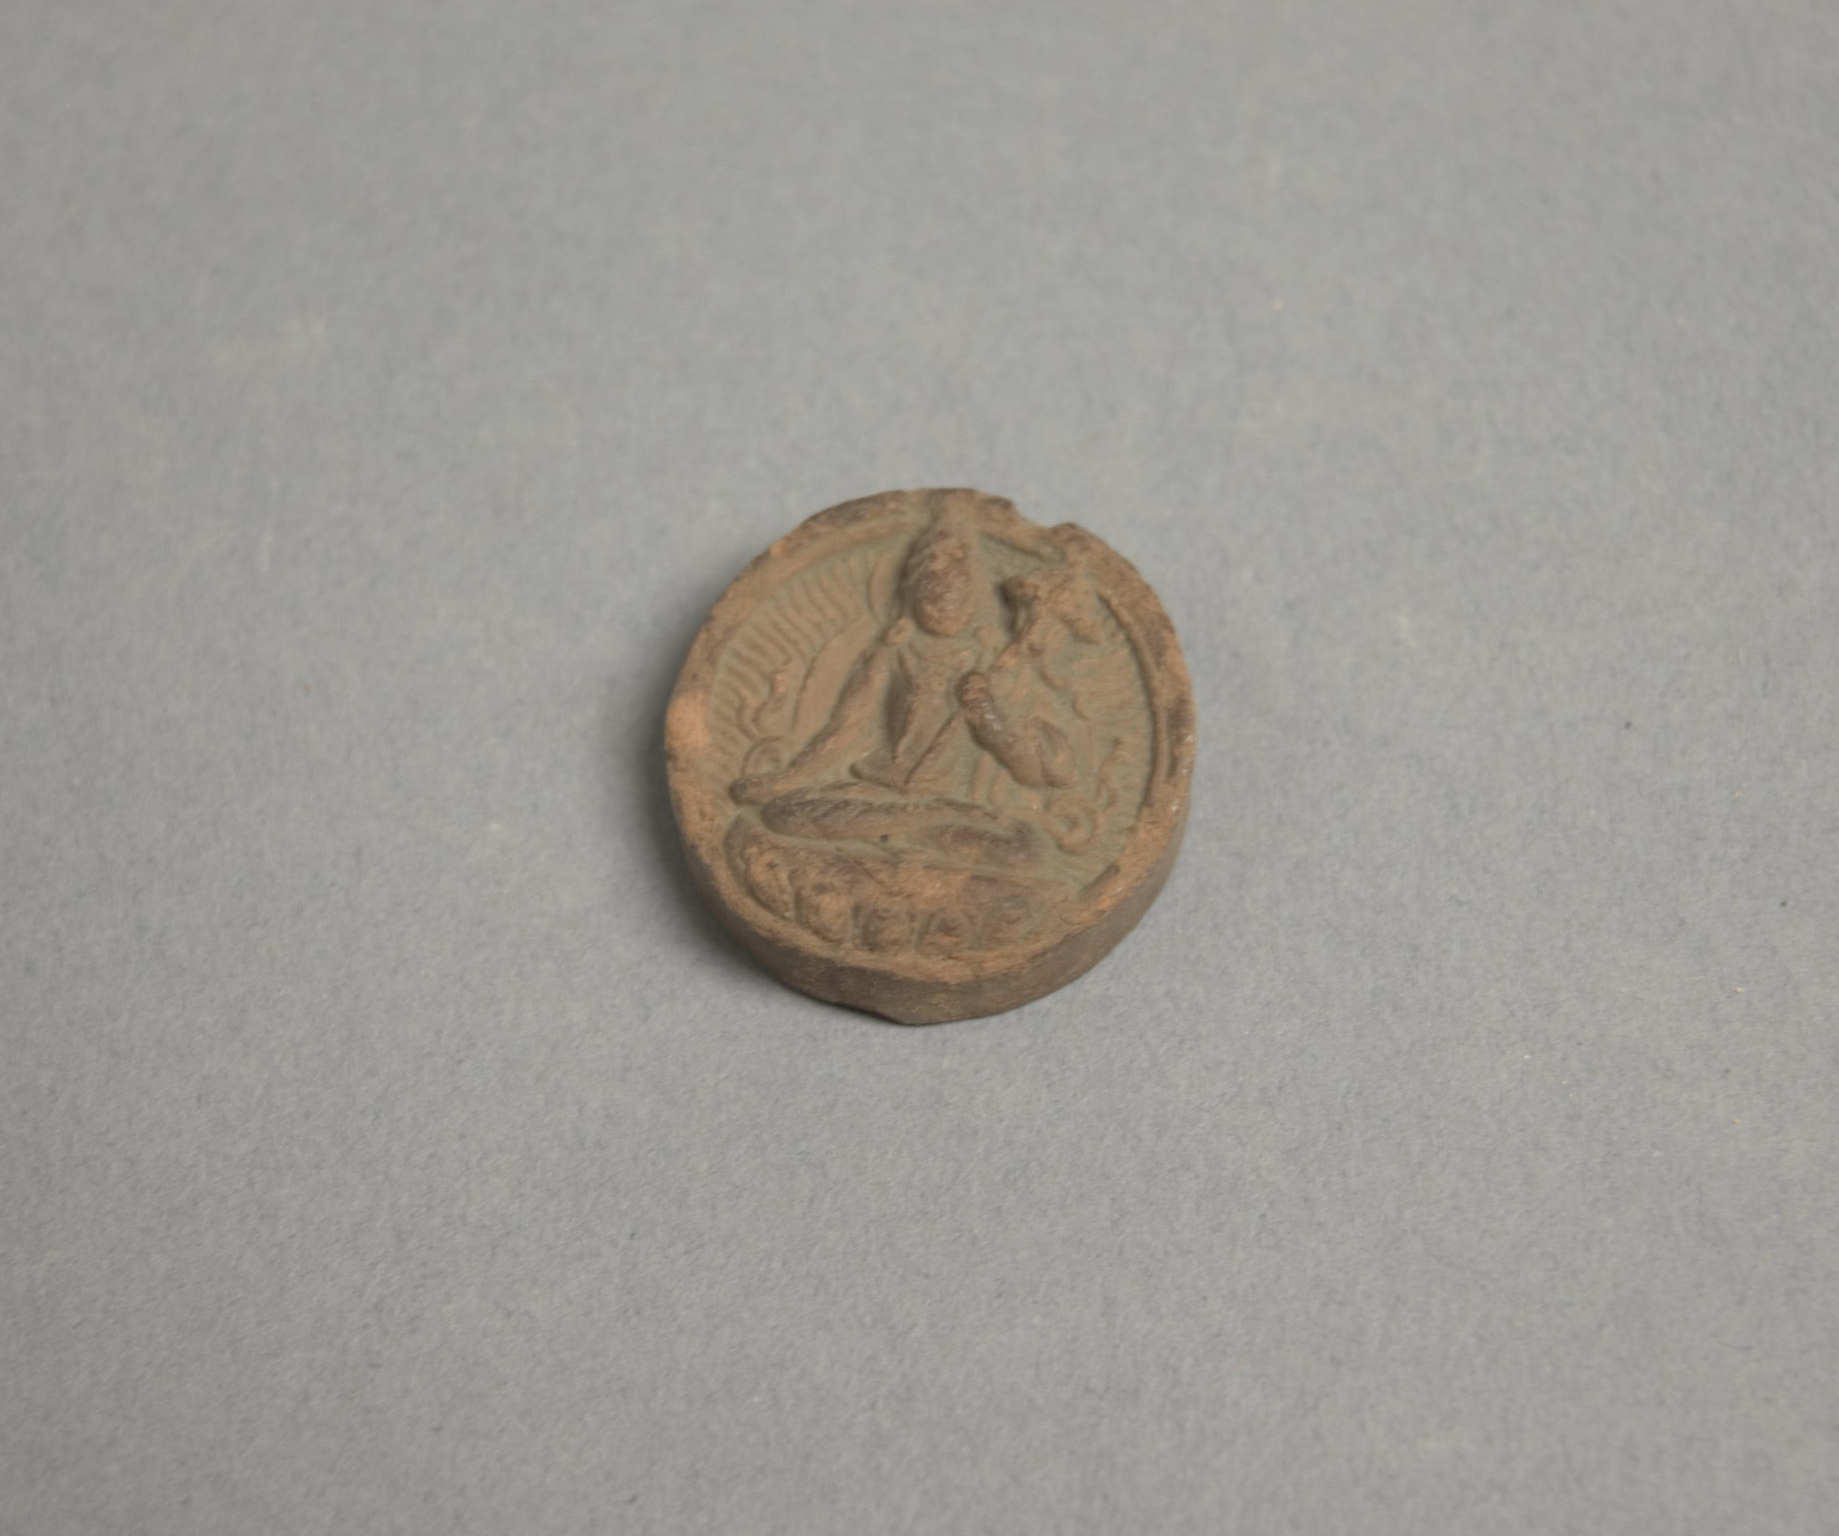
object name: plaque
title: Votive Plaque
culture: tibetan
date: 1368-1643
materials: clay